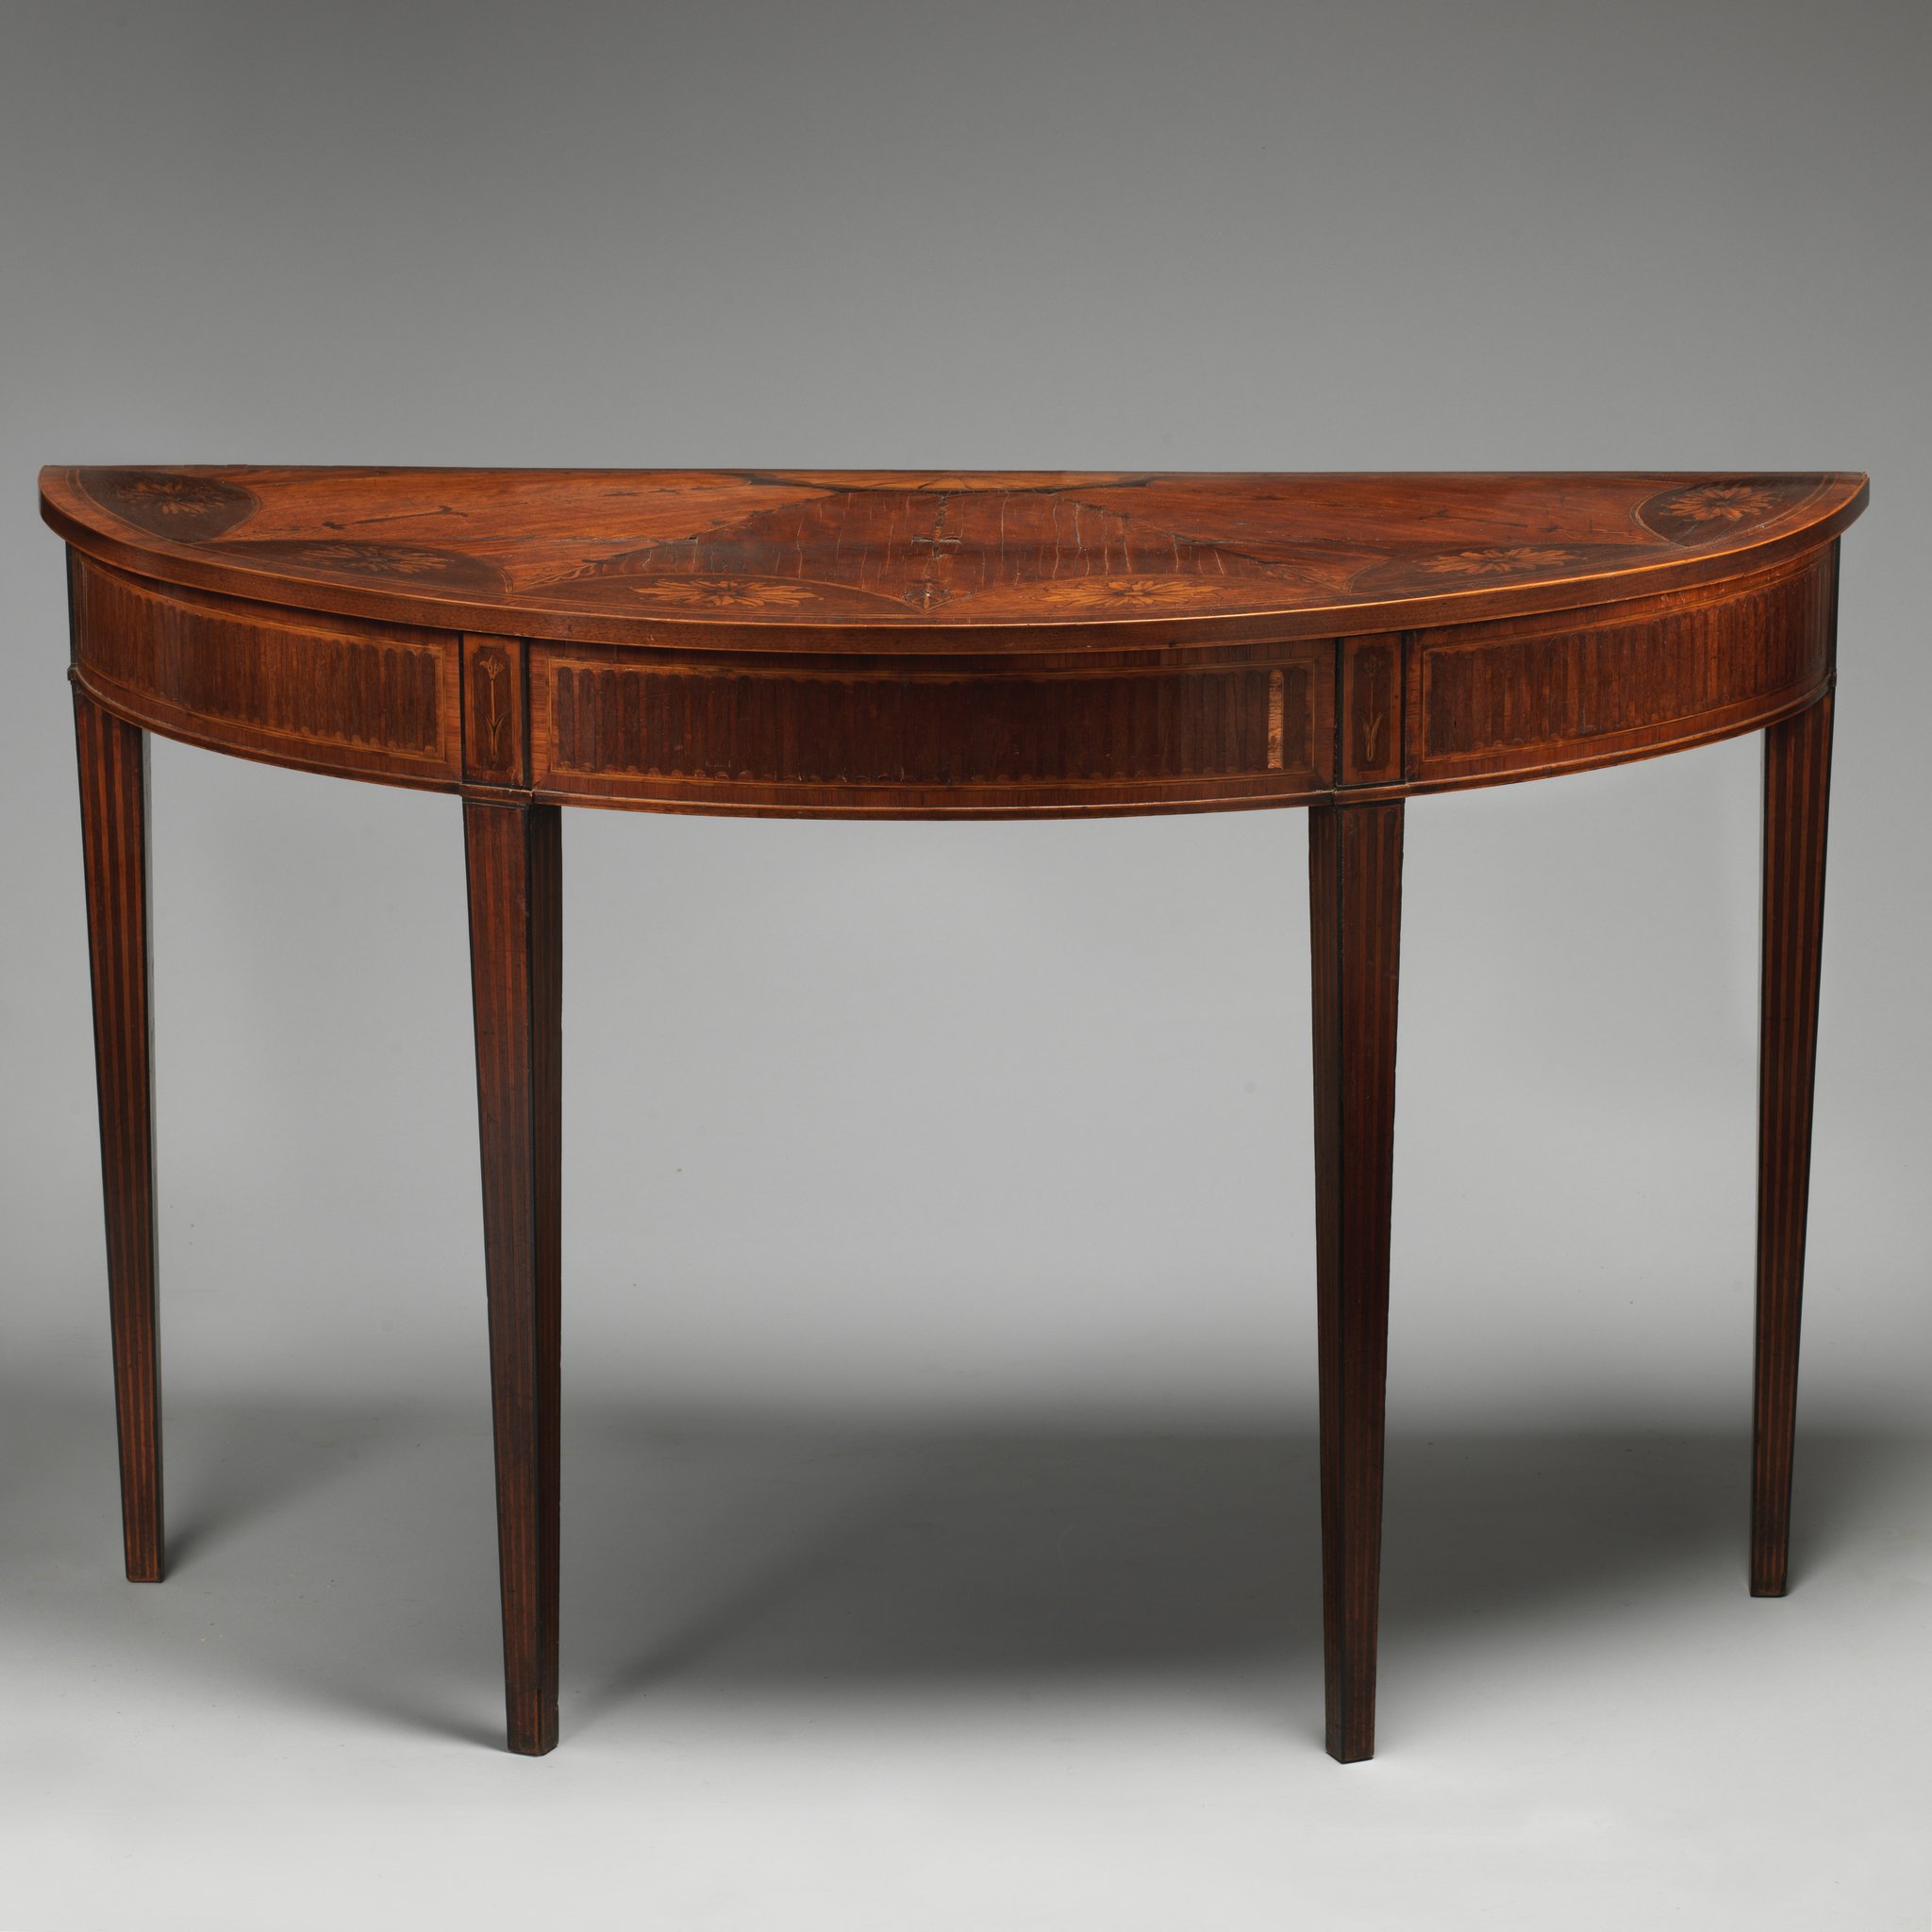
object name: side table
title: Side table (one of a pair)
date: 1790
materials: wood